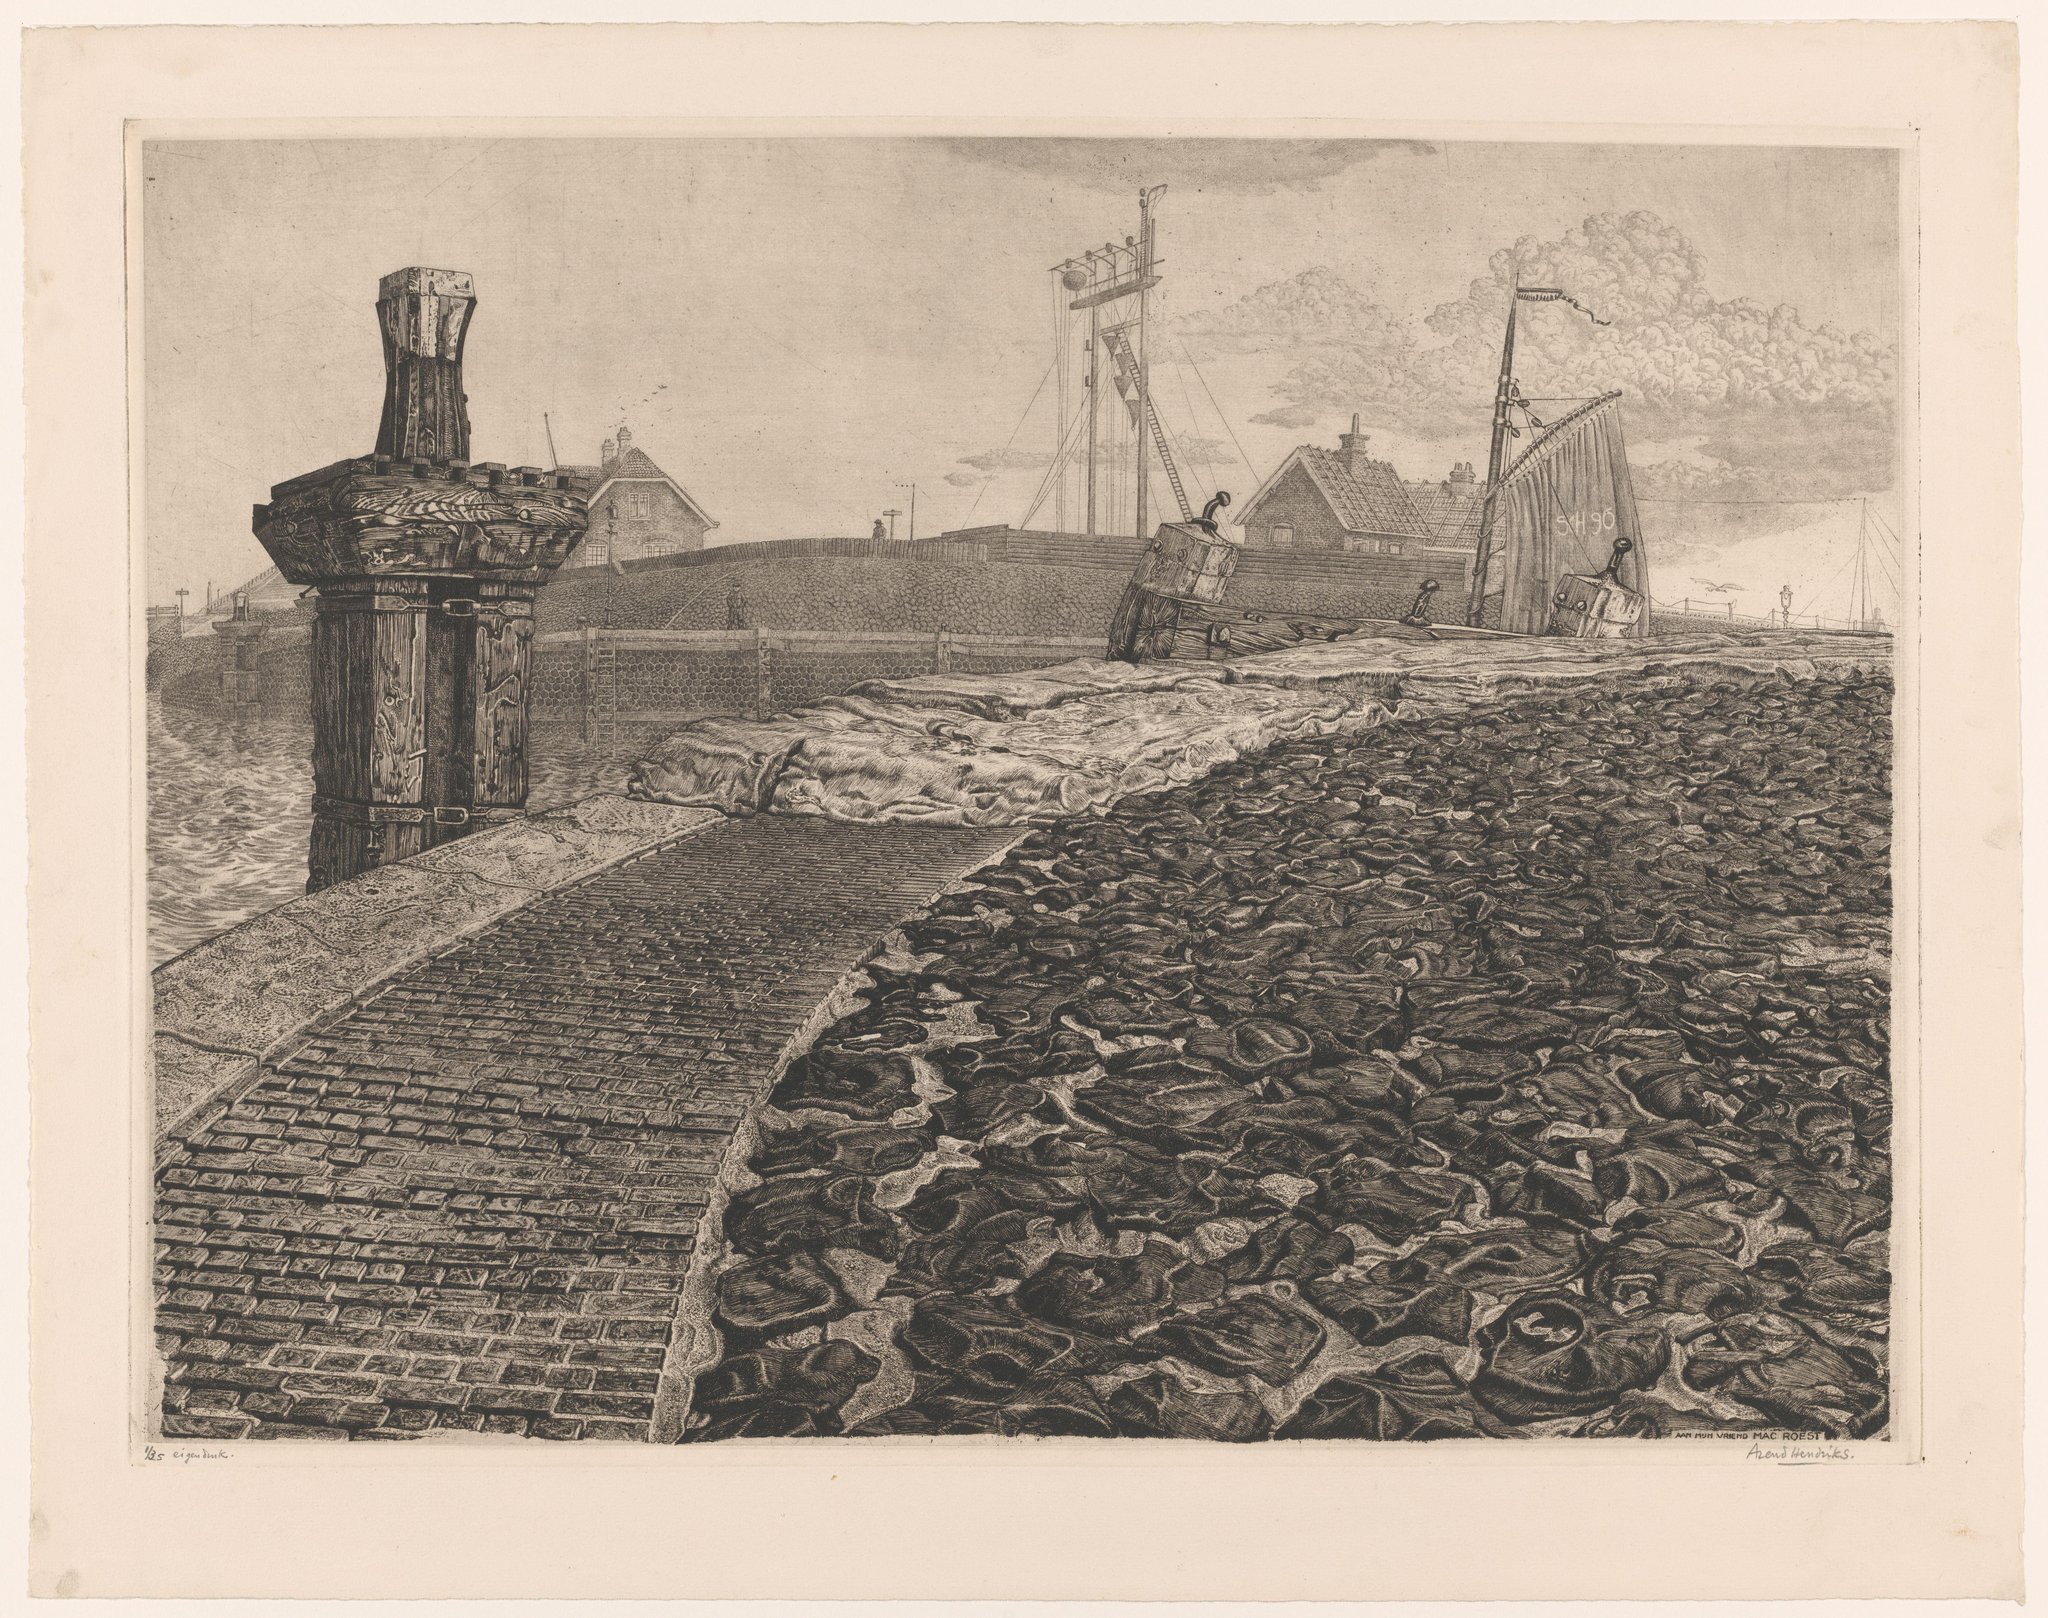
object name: print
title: Haven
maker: arend hendriks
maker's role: print maker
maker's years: 1901-1951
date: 1911-1938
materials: paper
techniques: etching, intaglio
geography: netherlands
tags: harbour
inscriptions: collector's mark: Lugt 2228